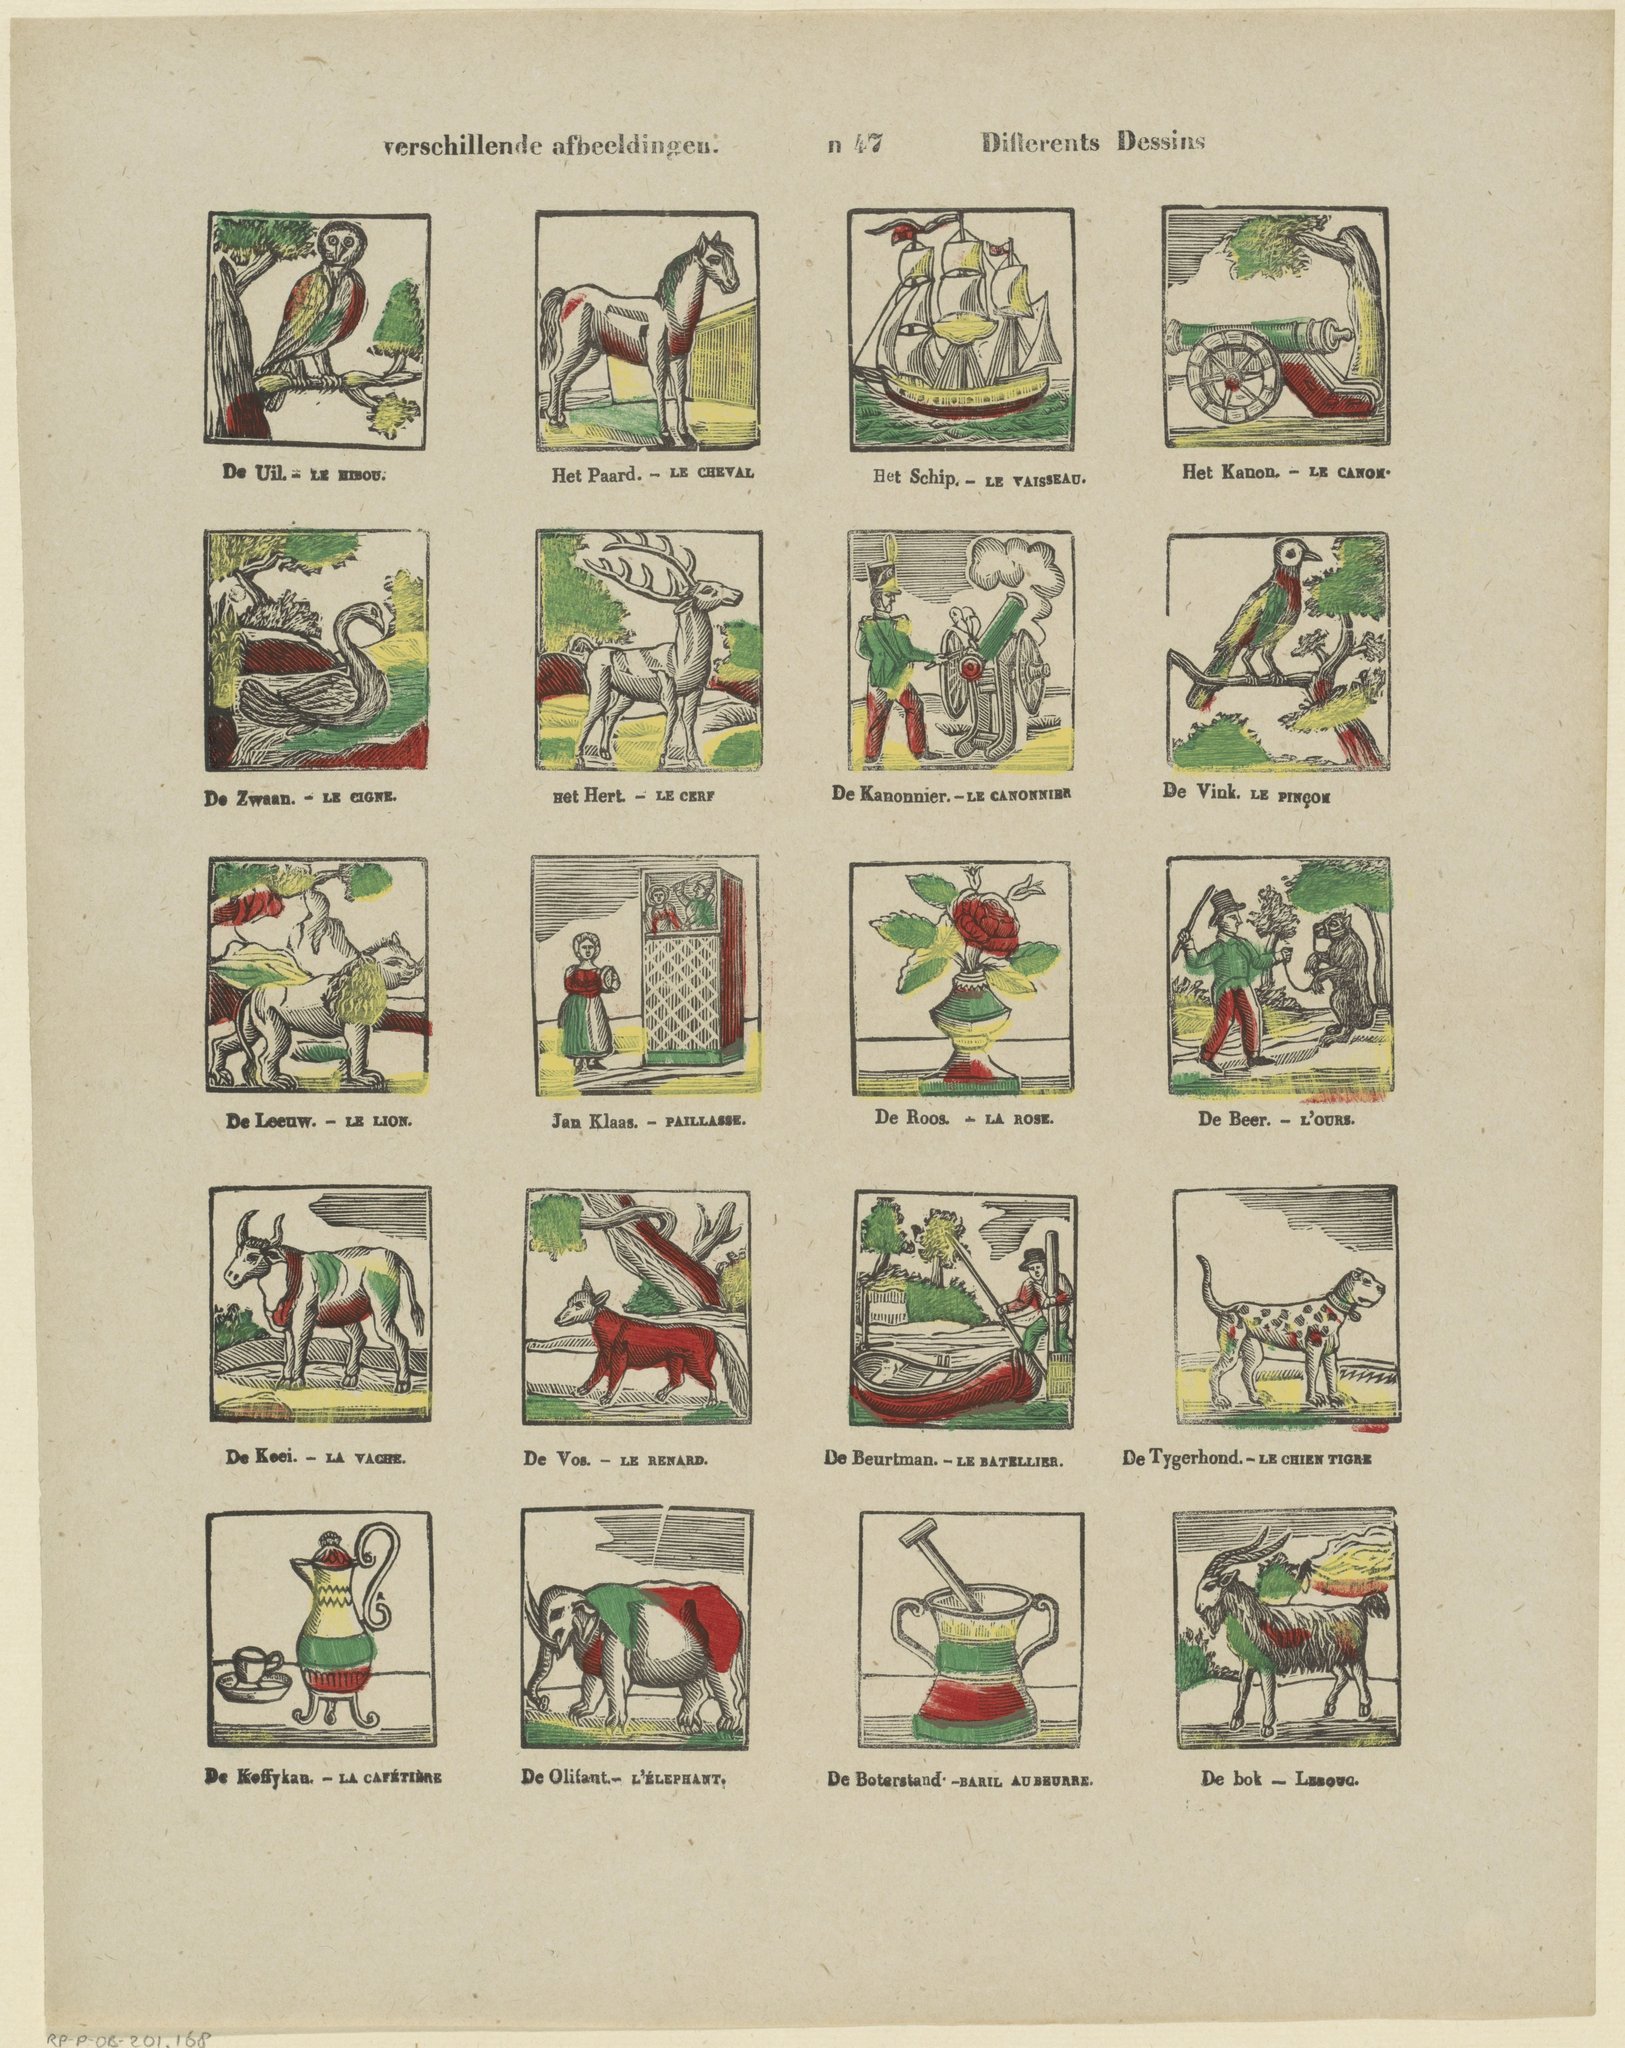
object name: popular print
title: Verschillende afbeeldingen / Differents dessins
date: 1866-1902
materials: paper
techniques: colour, letterpress printing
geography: turnhout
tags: kitchen-utensils, animals, ships (in general), characters (human types)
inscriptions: collector's mark: Lugt 2760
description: Blad met 20 voorstellingen van dieren, figuren en voorwerpen, waaronder een uil, een paard, een koffiekan en een bok. Onder elke afbeelding een onderschrift in het Nederlands en in het Frans. Genummerd midden boven: n 47.